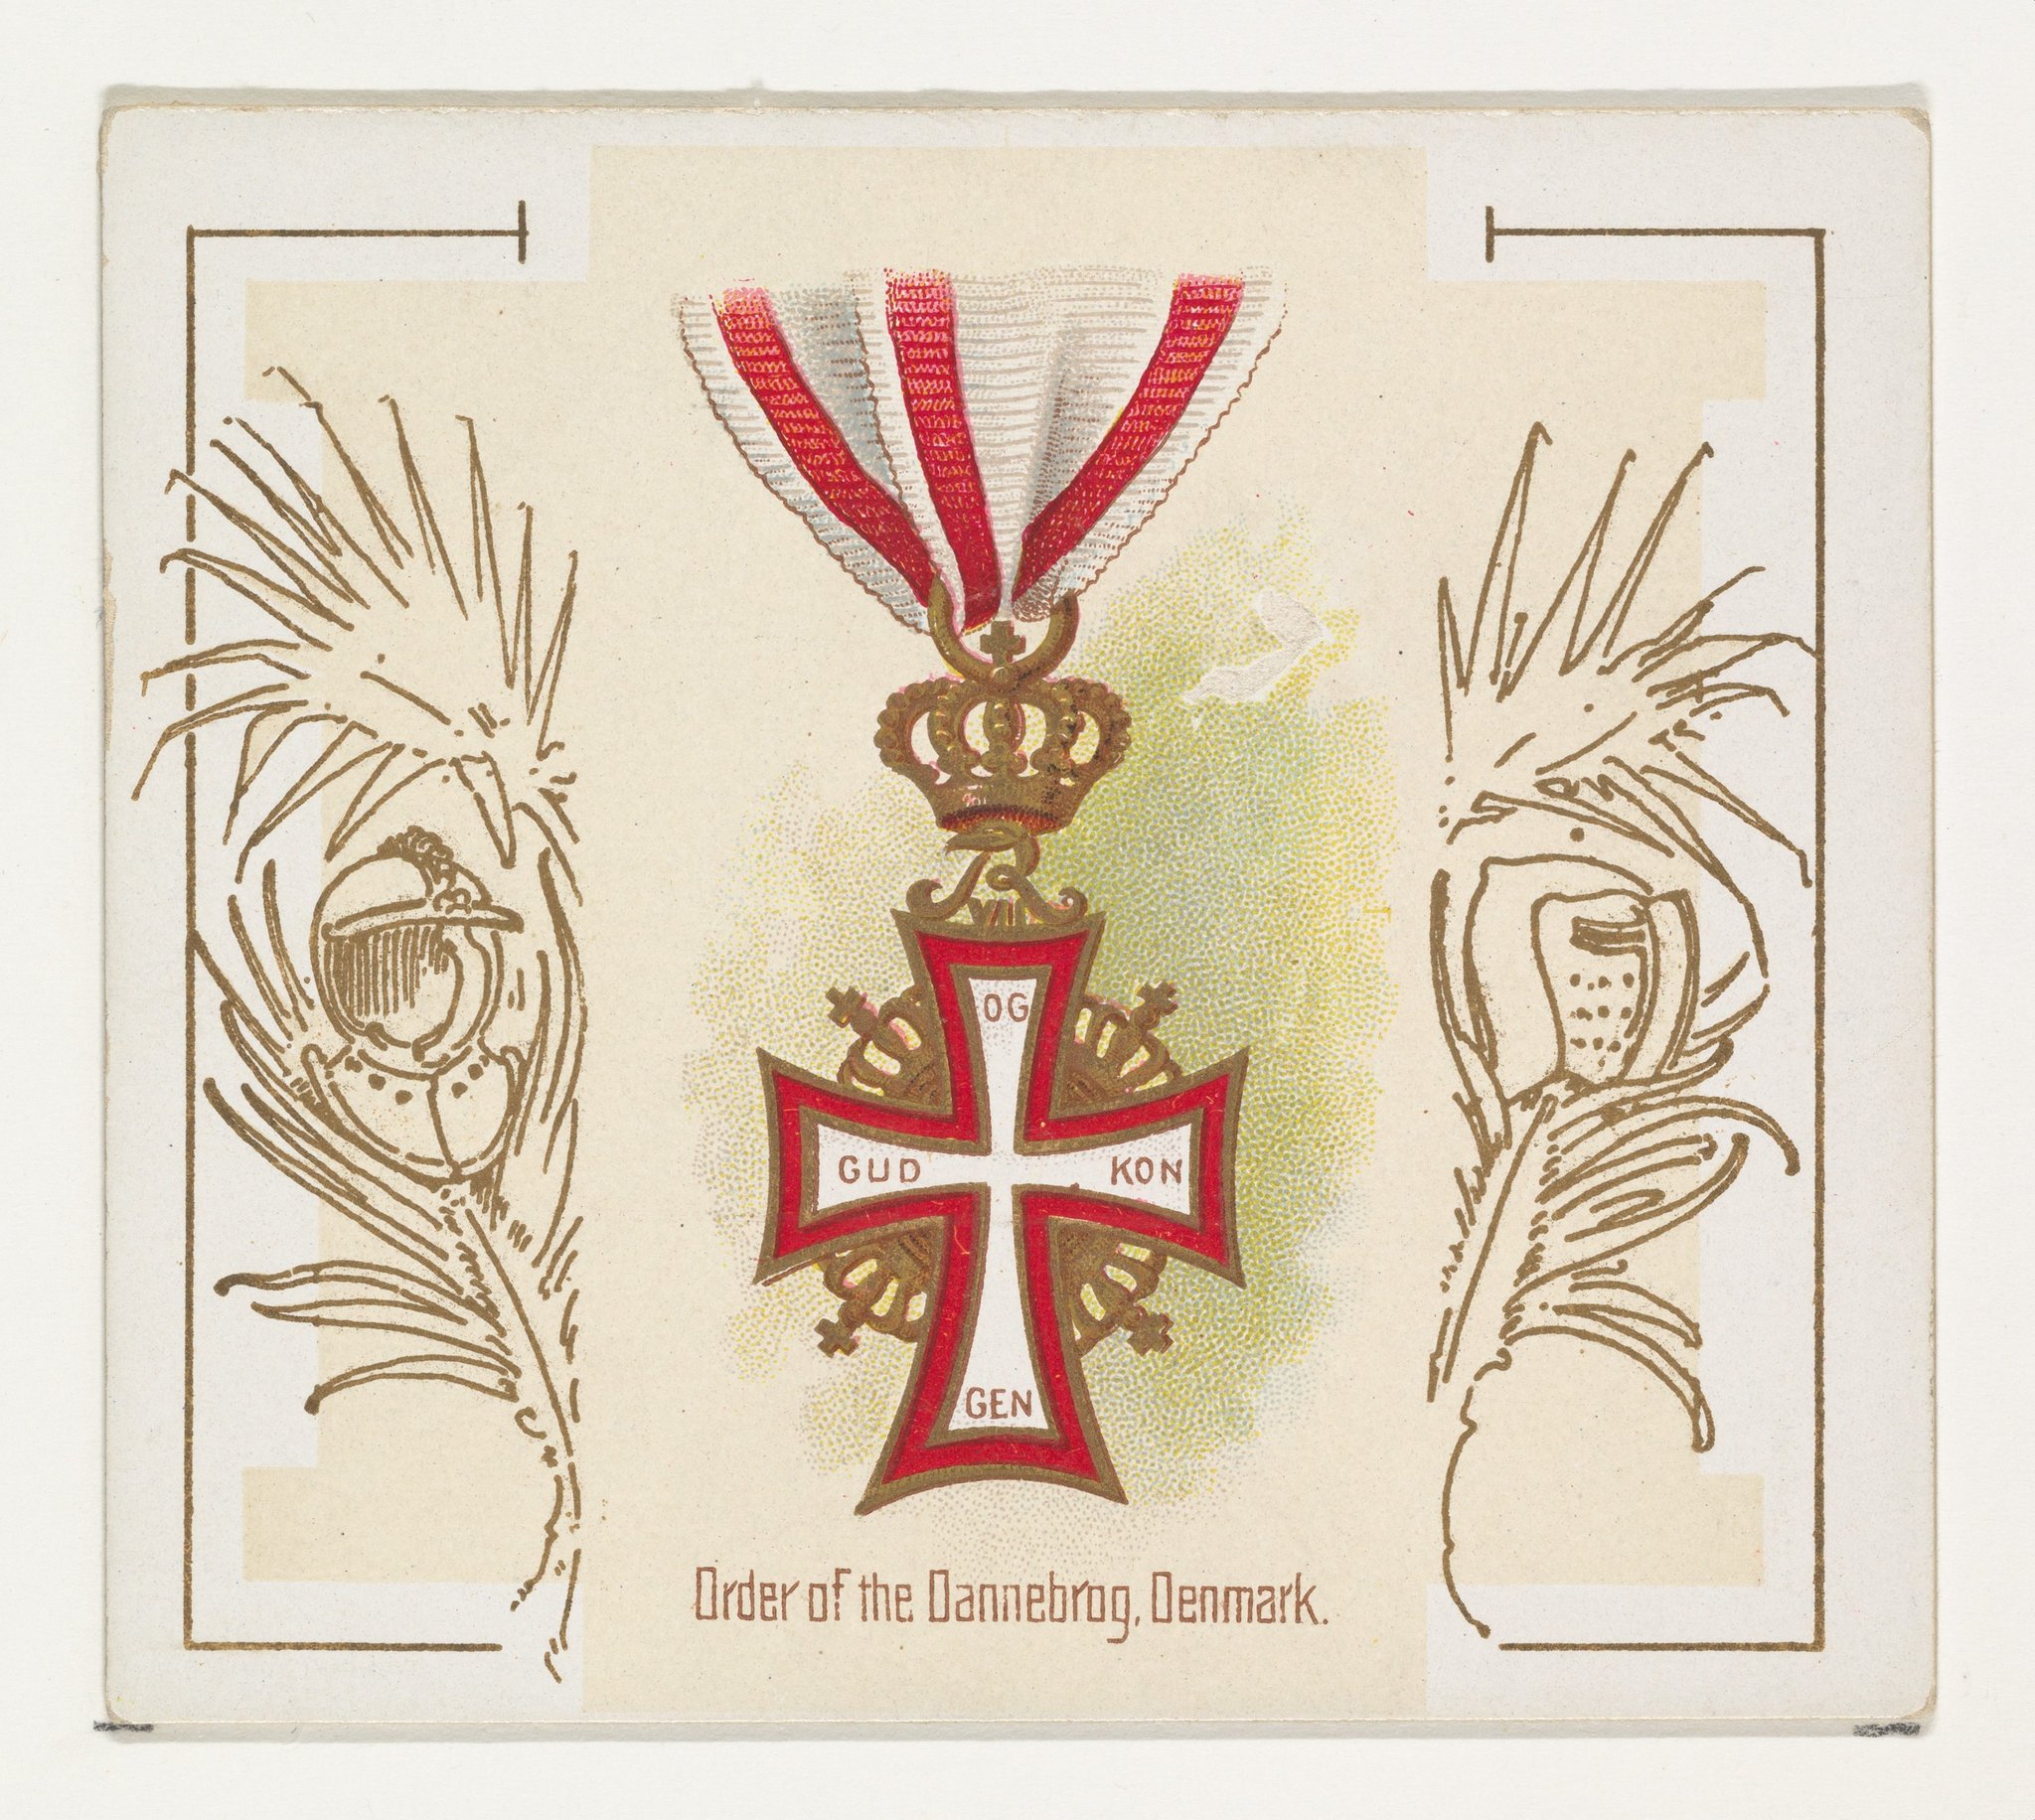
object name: print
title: Order of the Dannebrog, Denmark, from the World's Decorations series (N44) for Allen & Ginter Cigarettes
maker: allen & ginter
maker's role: publisher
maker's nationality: american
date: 1890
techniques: color lithograph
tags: medals